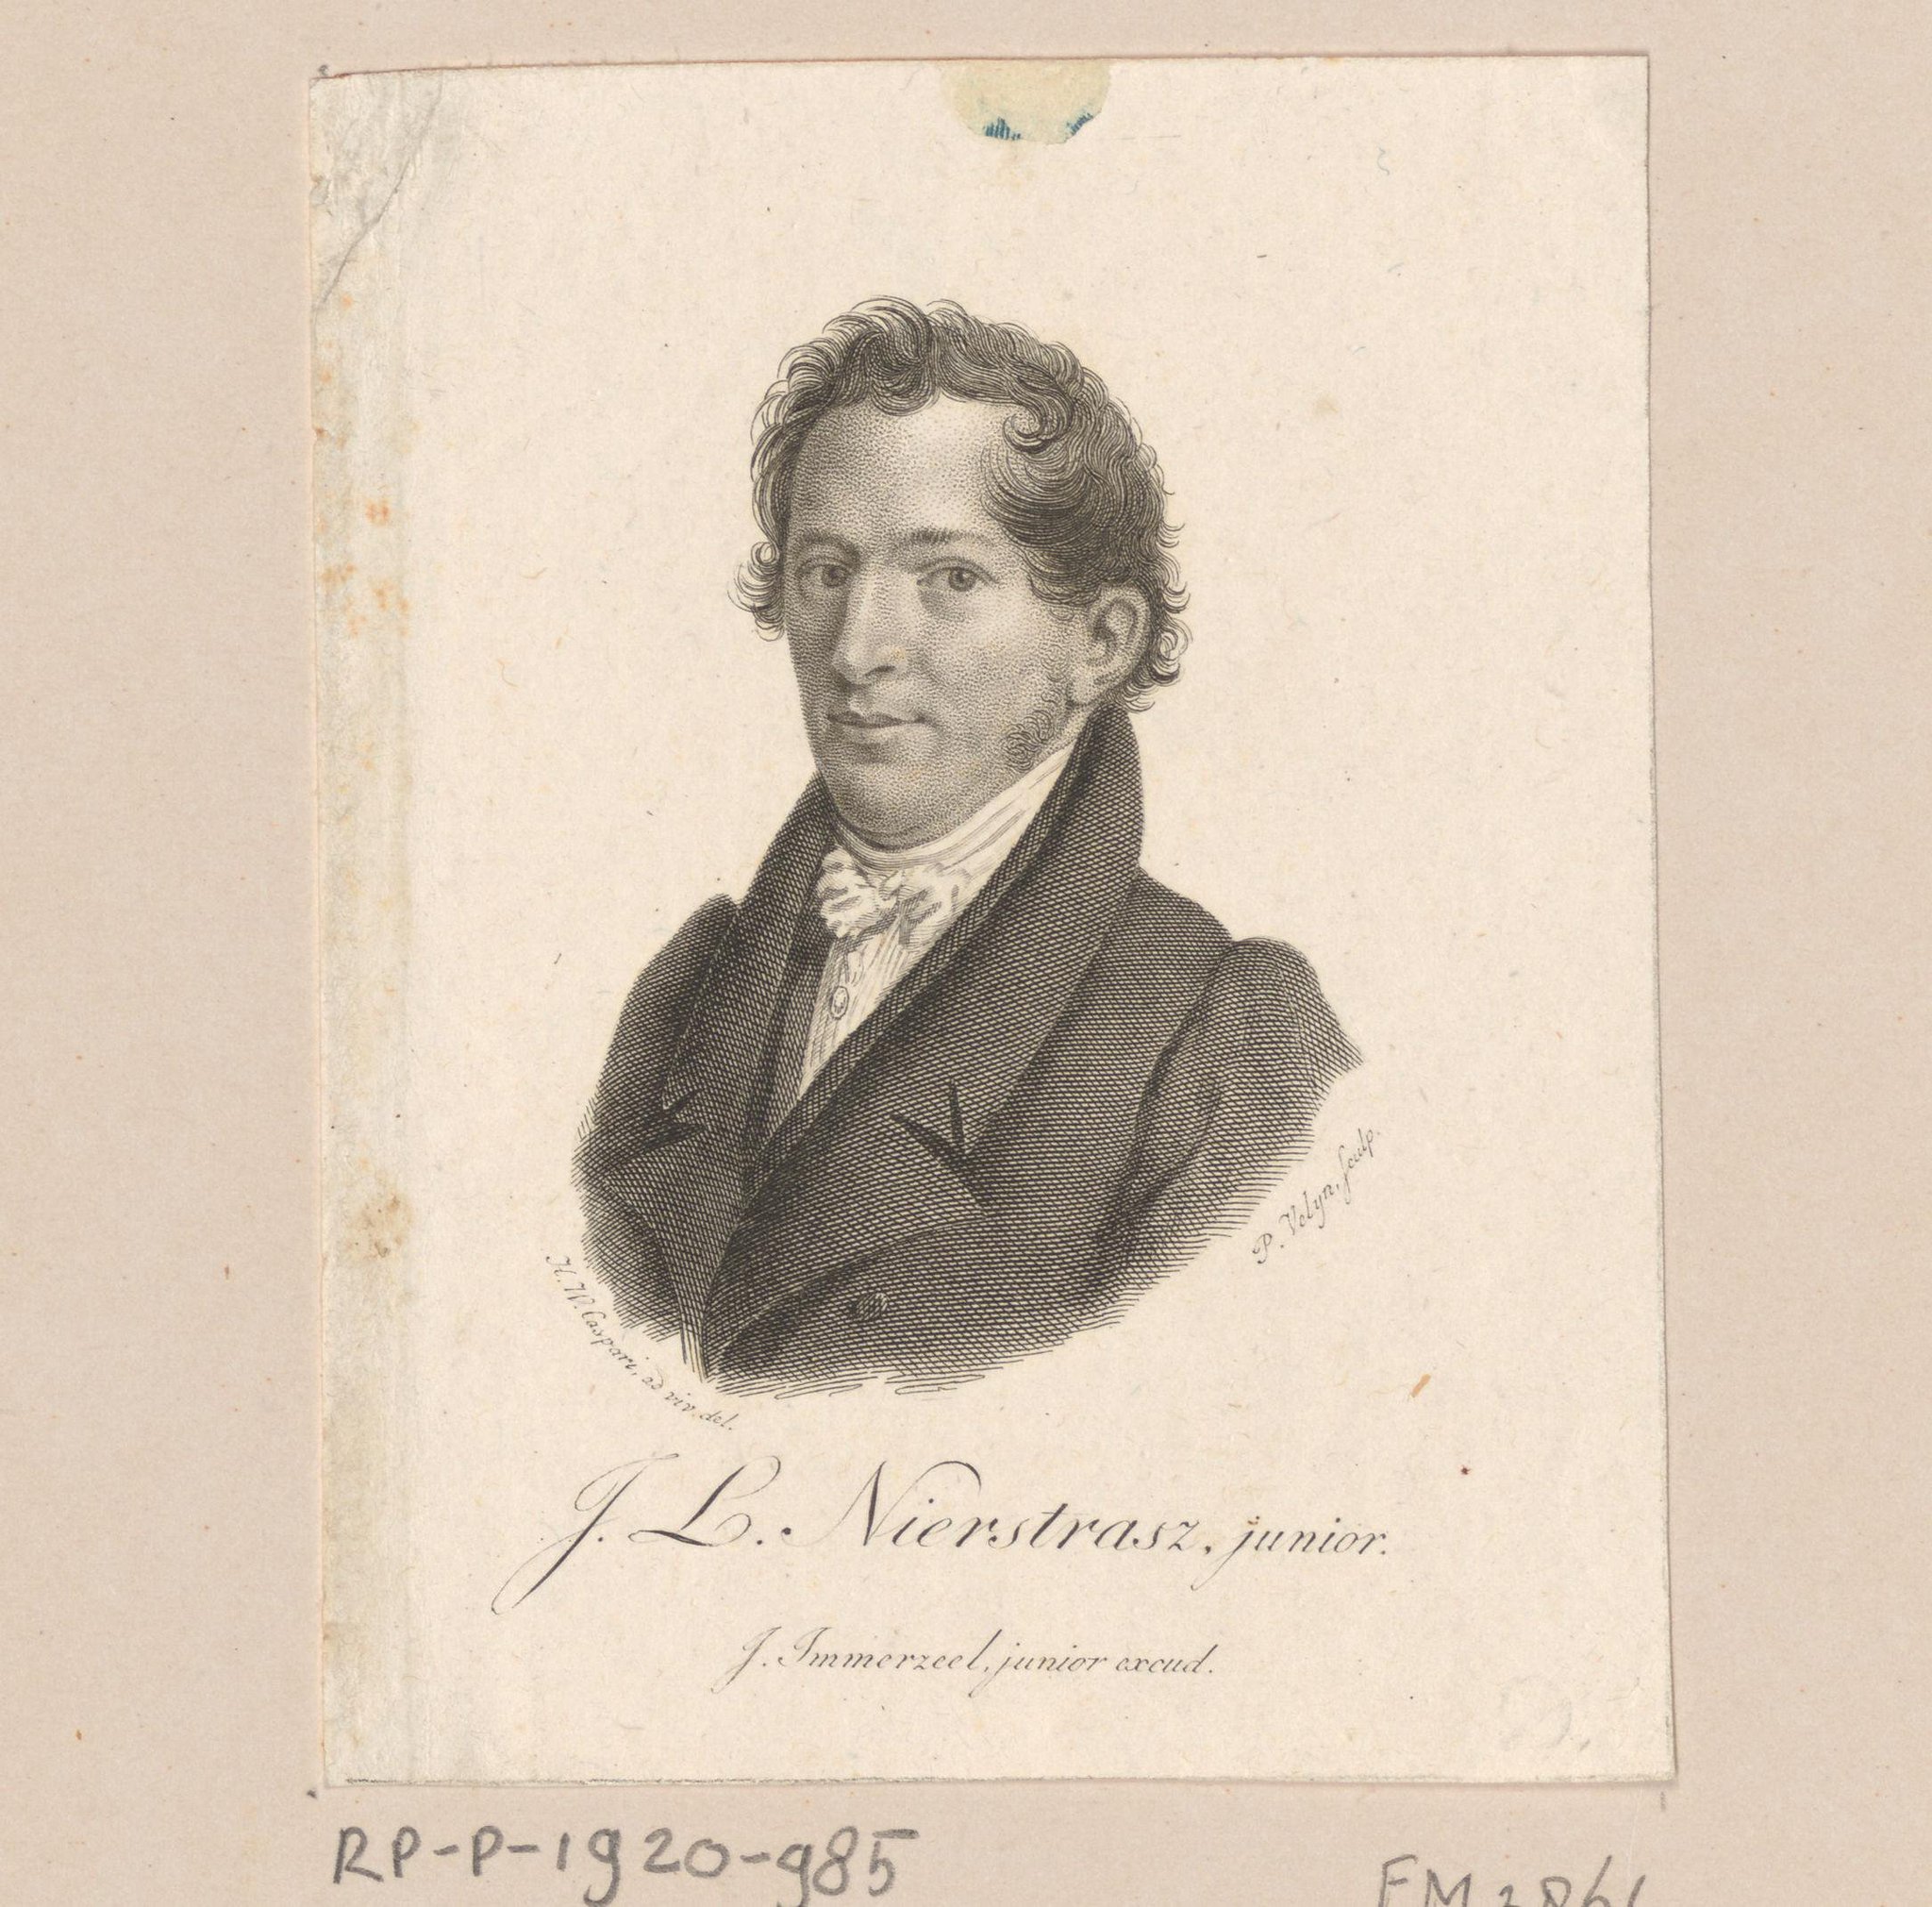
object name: print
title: Portret van Johannes Leonardus Nierstrasz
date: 1811-1836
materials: paper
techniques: engraving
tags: rotterdam, historical persons, writer, poet, author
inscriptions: collector's mark: Lugt 2228